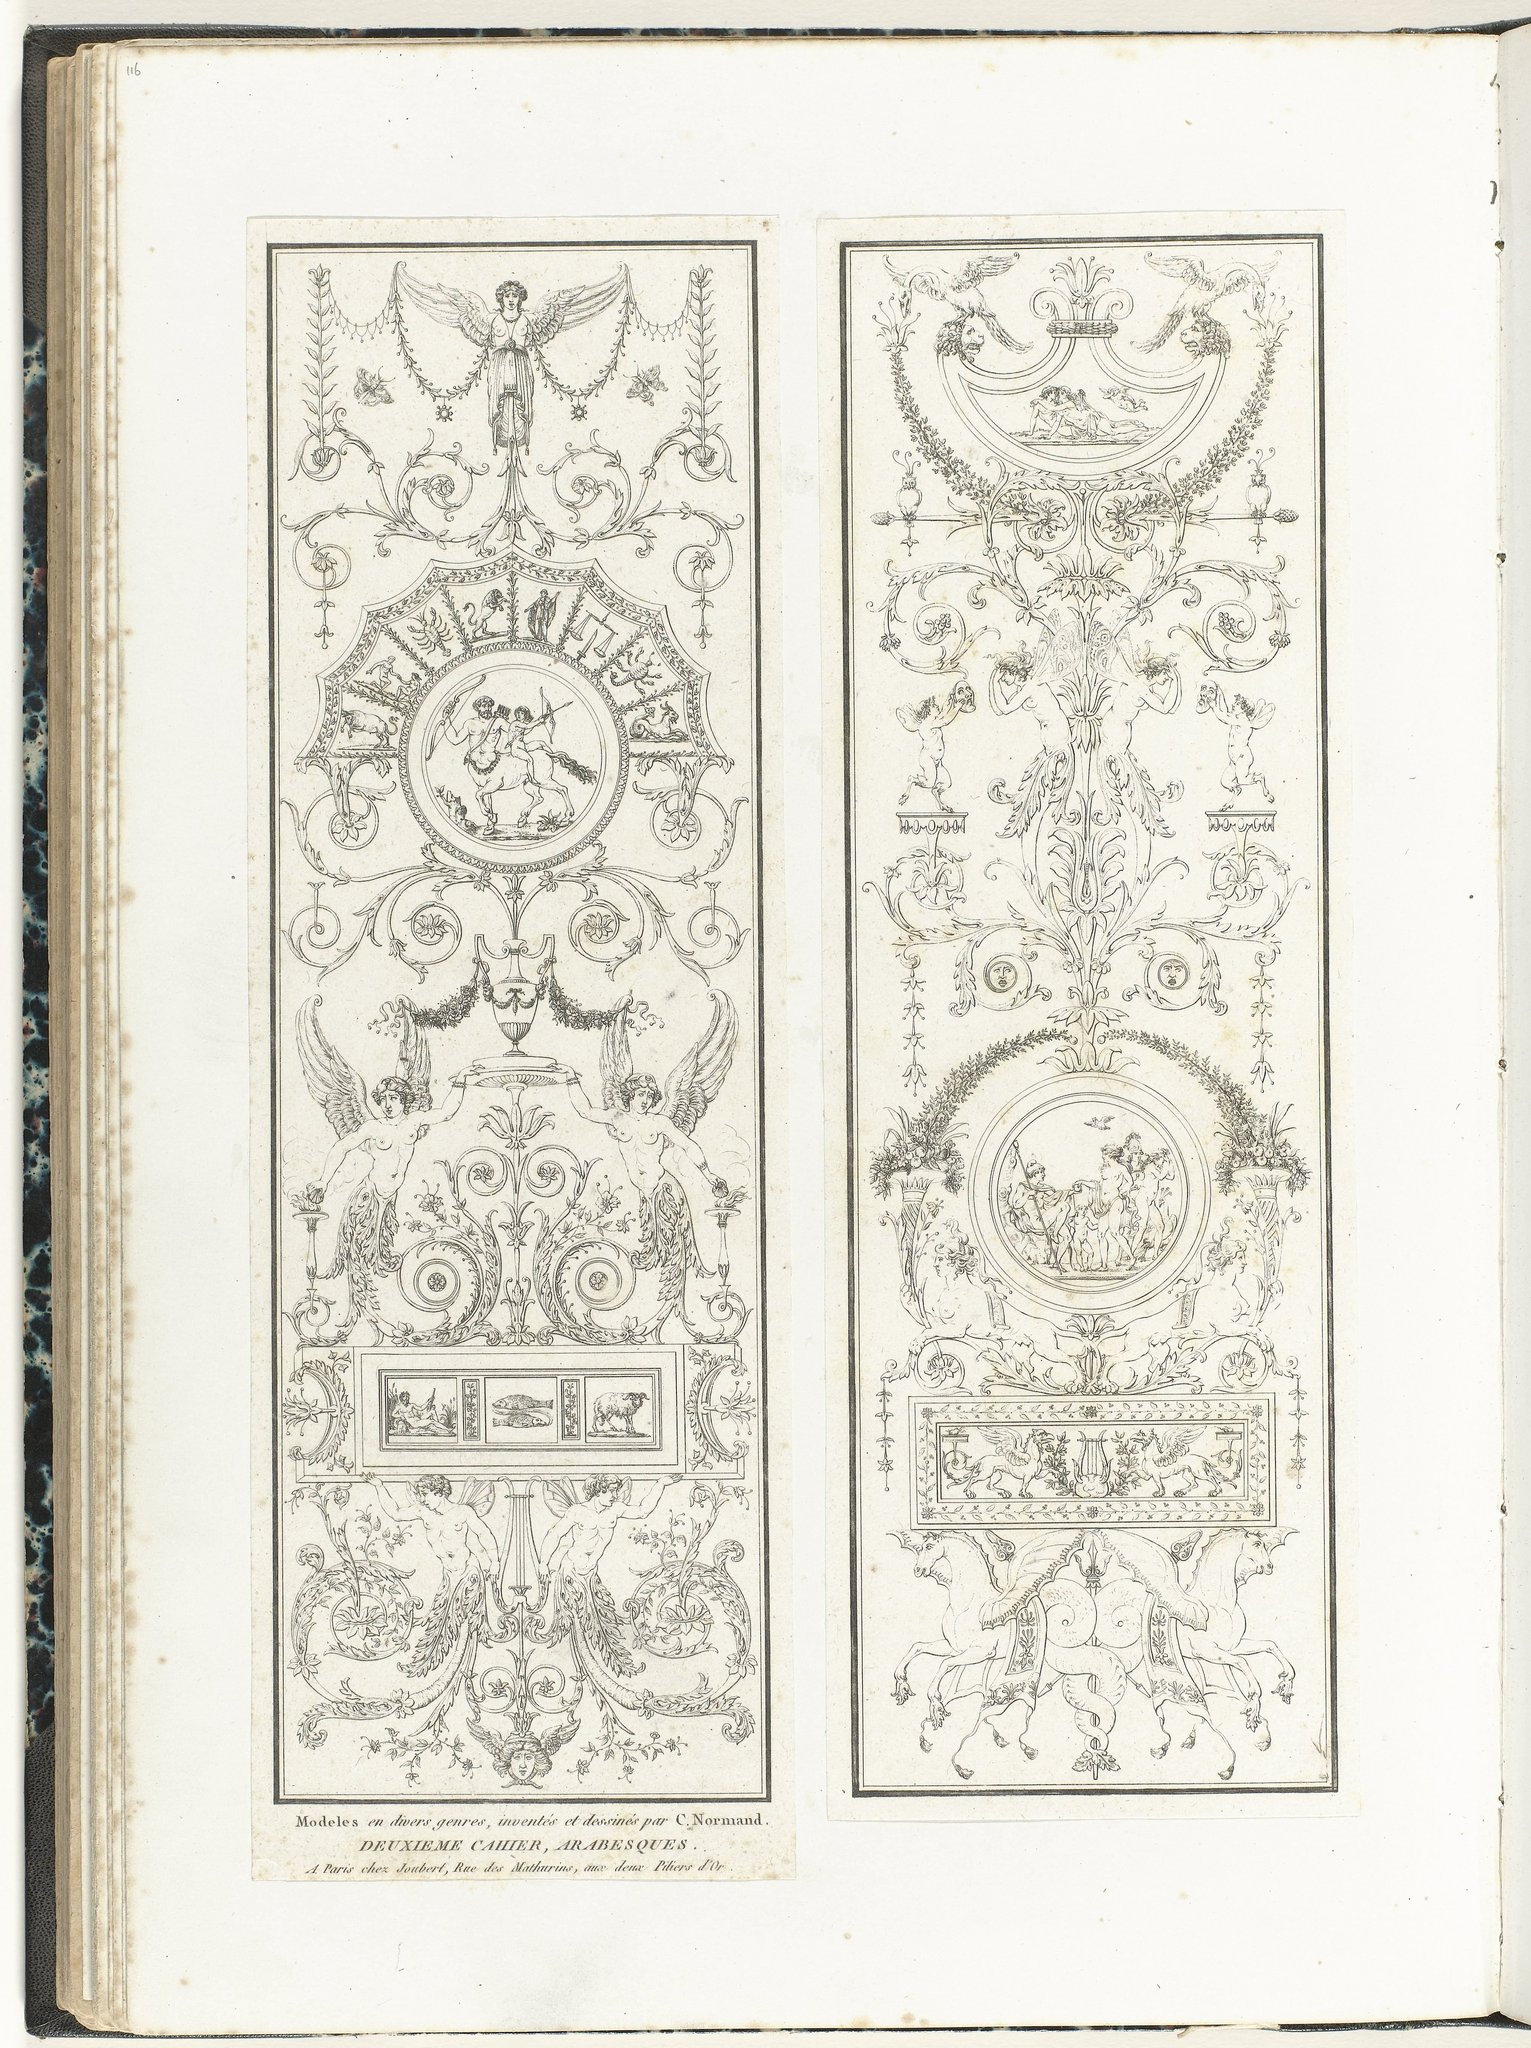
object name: print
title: Deuxieme Cahier, Arabesques.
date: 1866-1900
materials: paper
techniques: lithograph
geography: paris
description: Op het paneel links bevindt zich bovenaan een medaillon met een centaur waarop een jongen met pijl en boog zit, op het paneel rechts staan onderaan twee gevleugelde paarden met een staart en hoeven die uitlopen in bladranken.